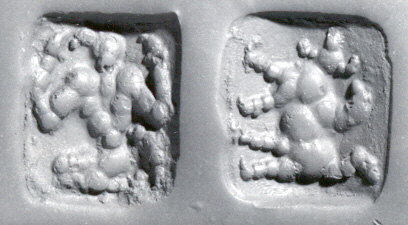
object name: stamp seal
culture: bactria-margiana archaeological complex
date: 2333-1668 BCE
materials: lapis lazuli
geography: bactria-margiana